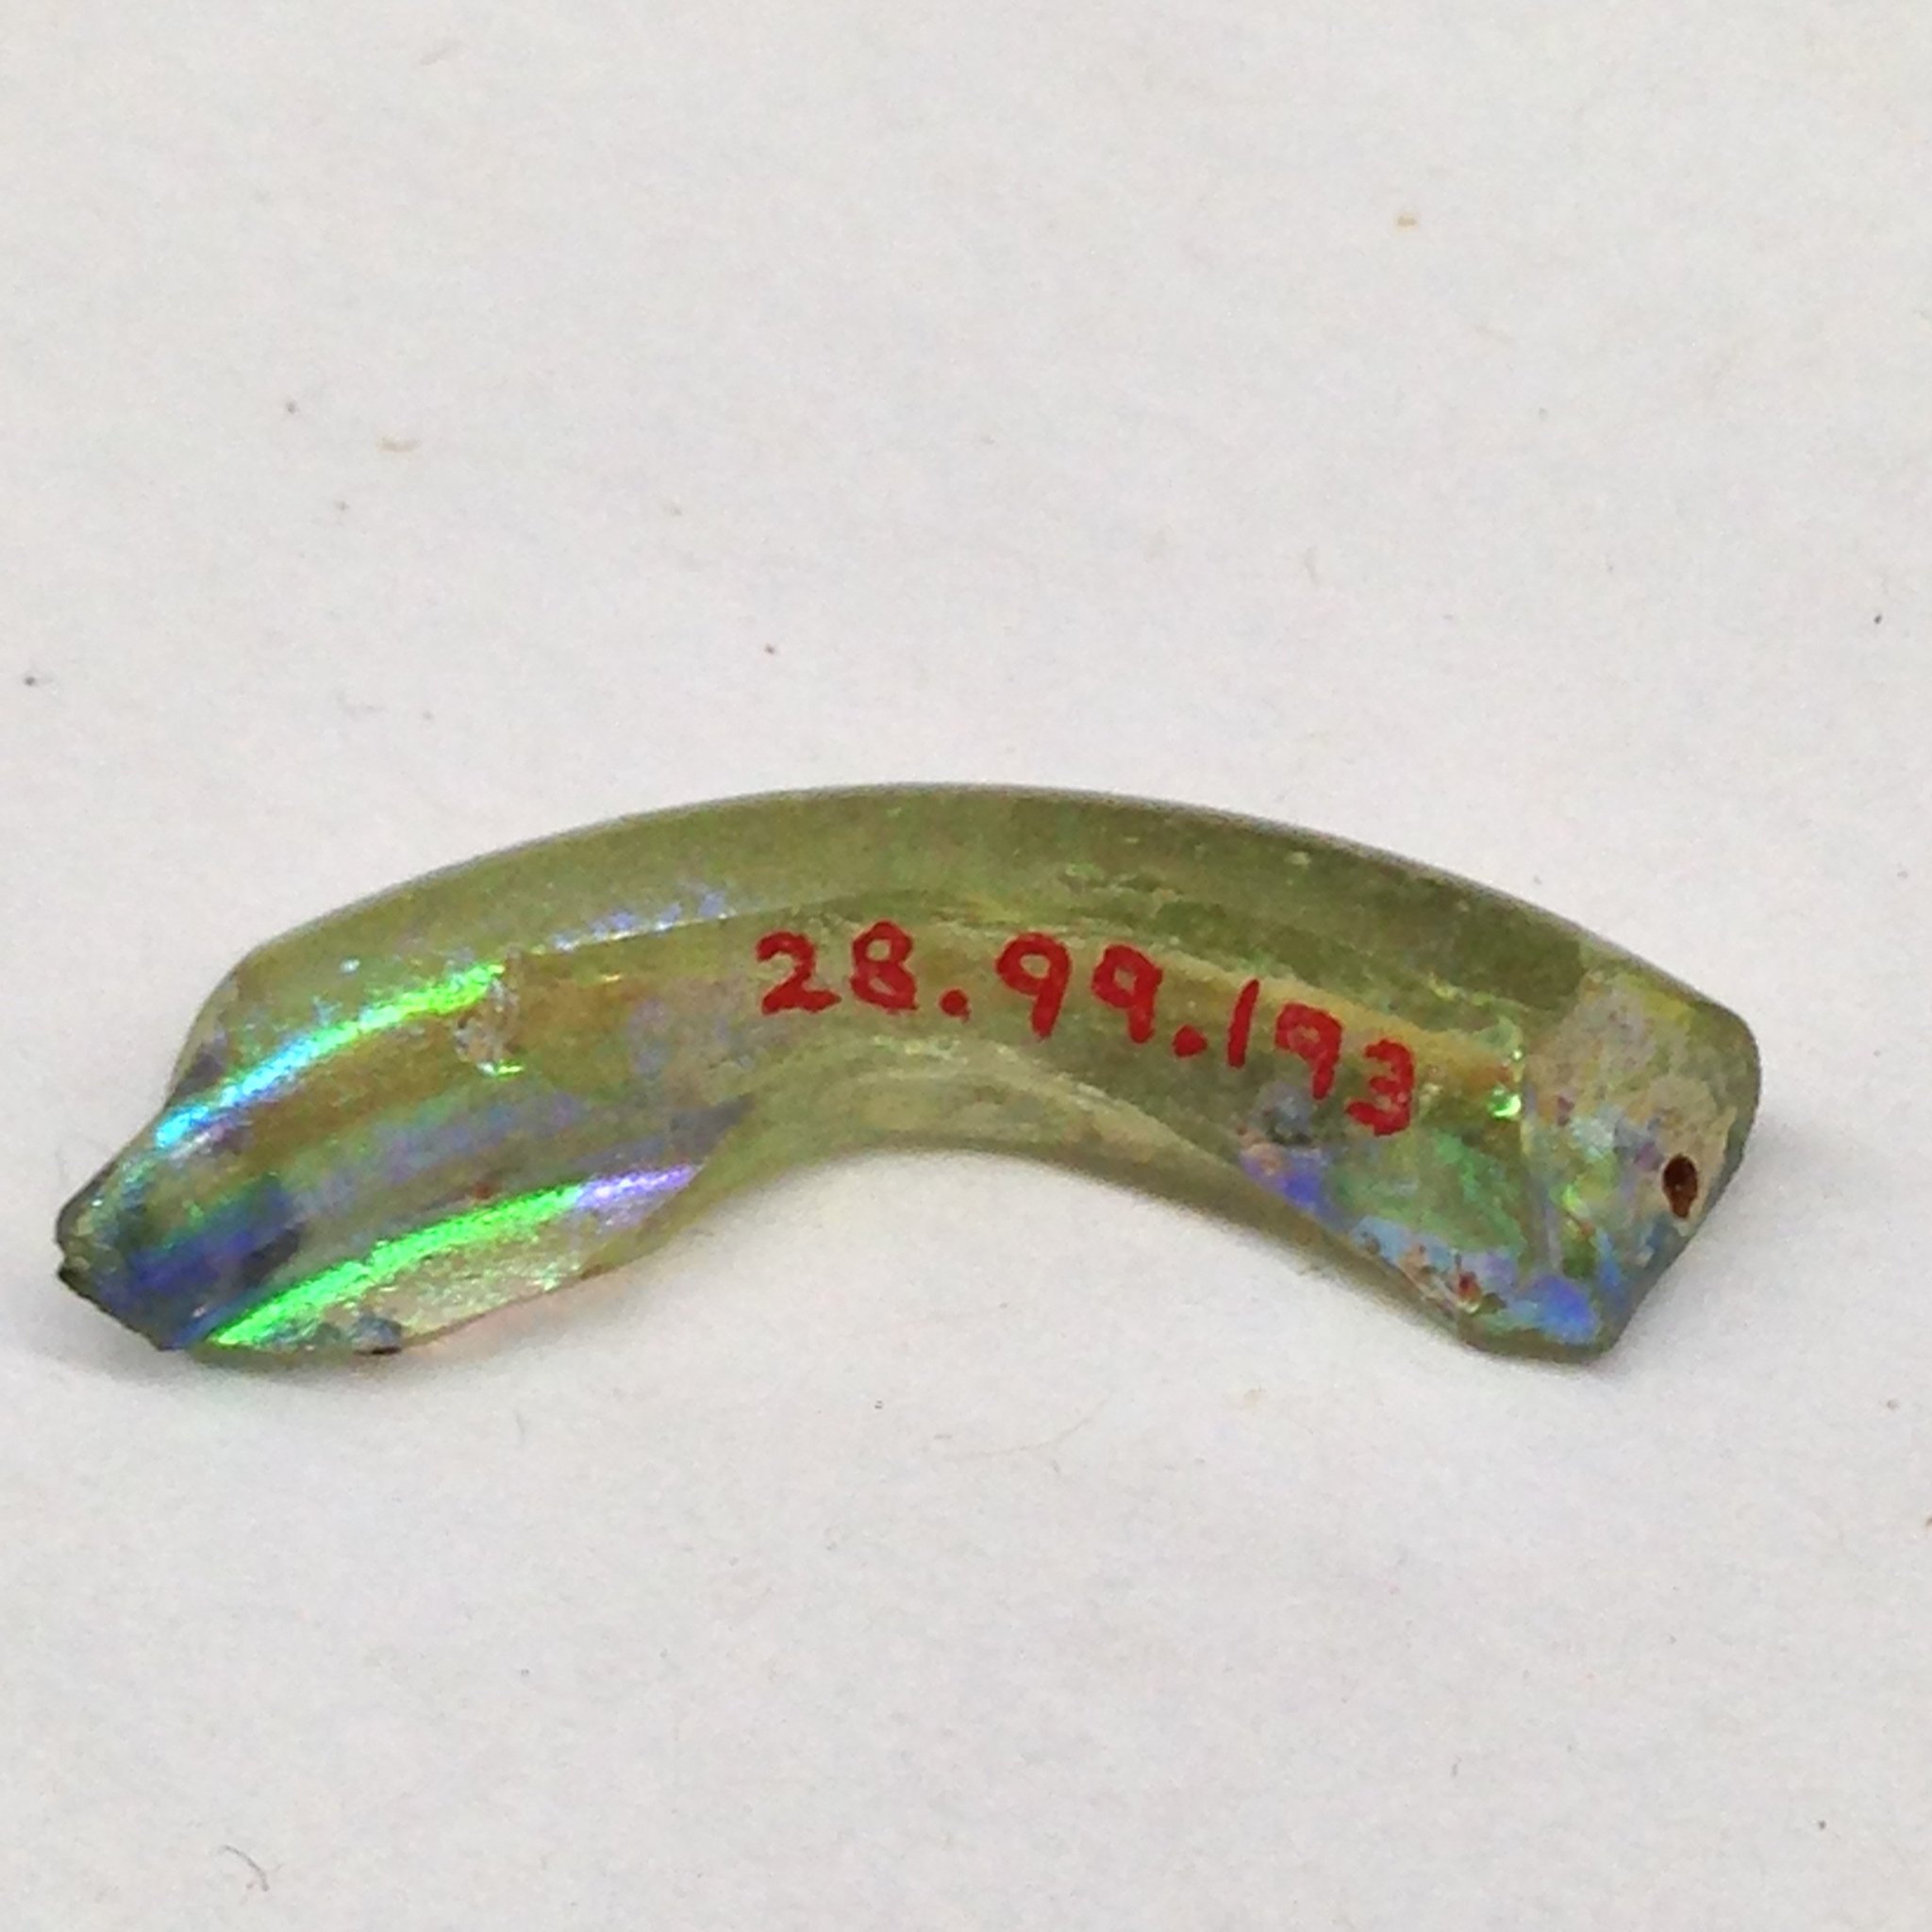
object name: fragment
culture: european or middle eastern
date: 1150-1250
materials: ceramic, glass